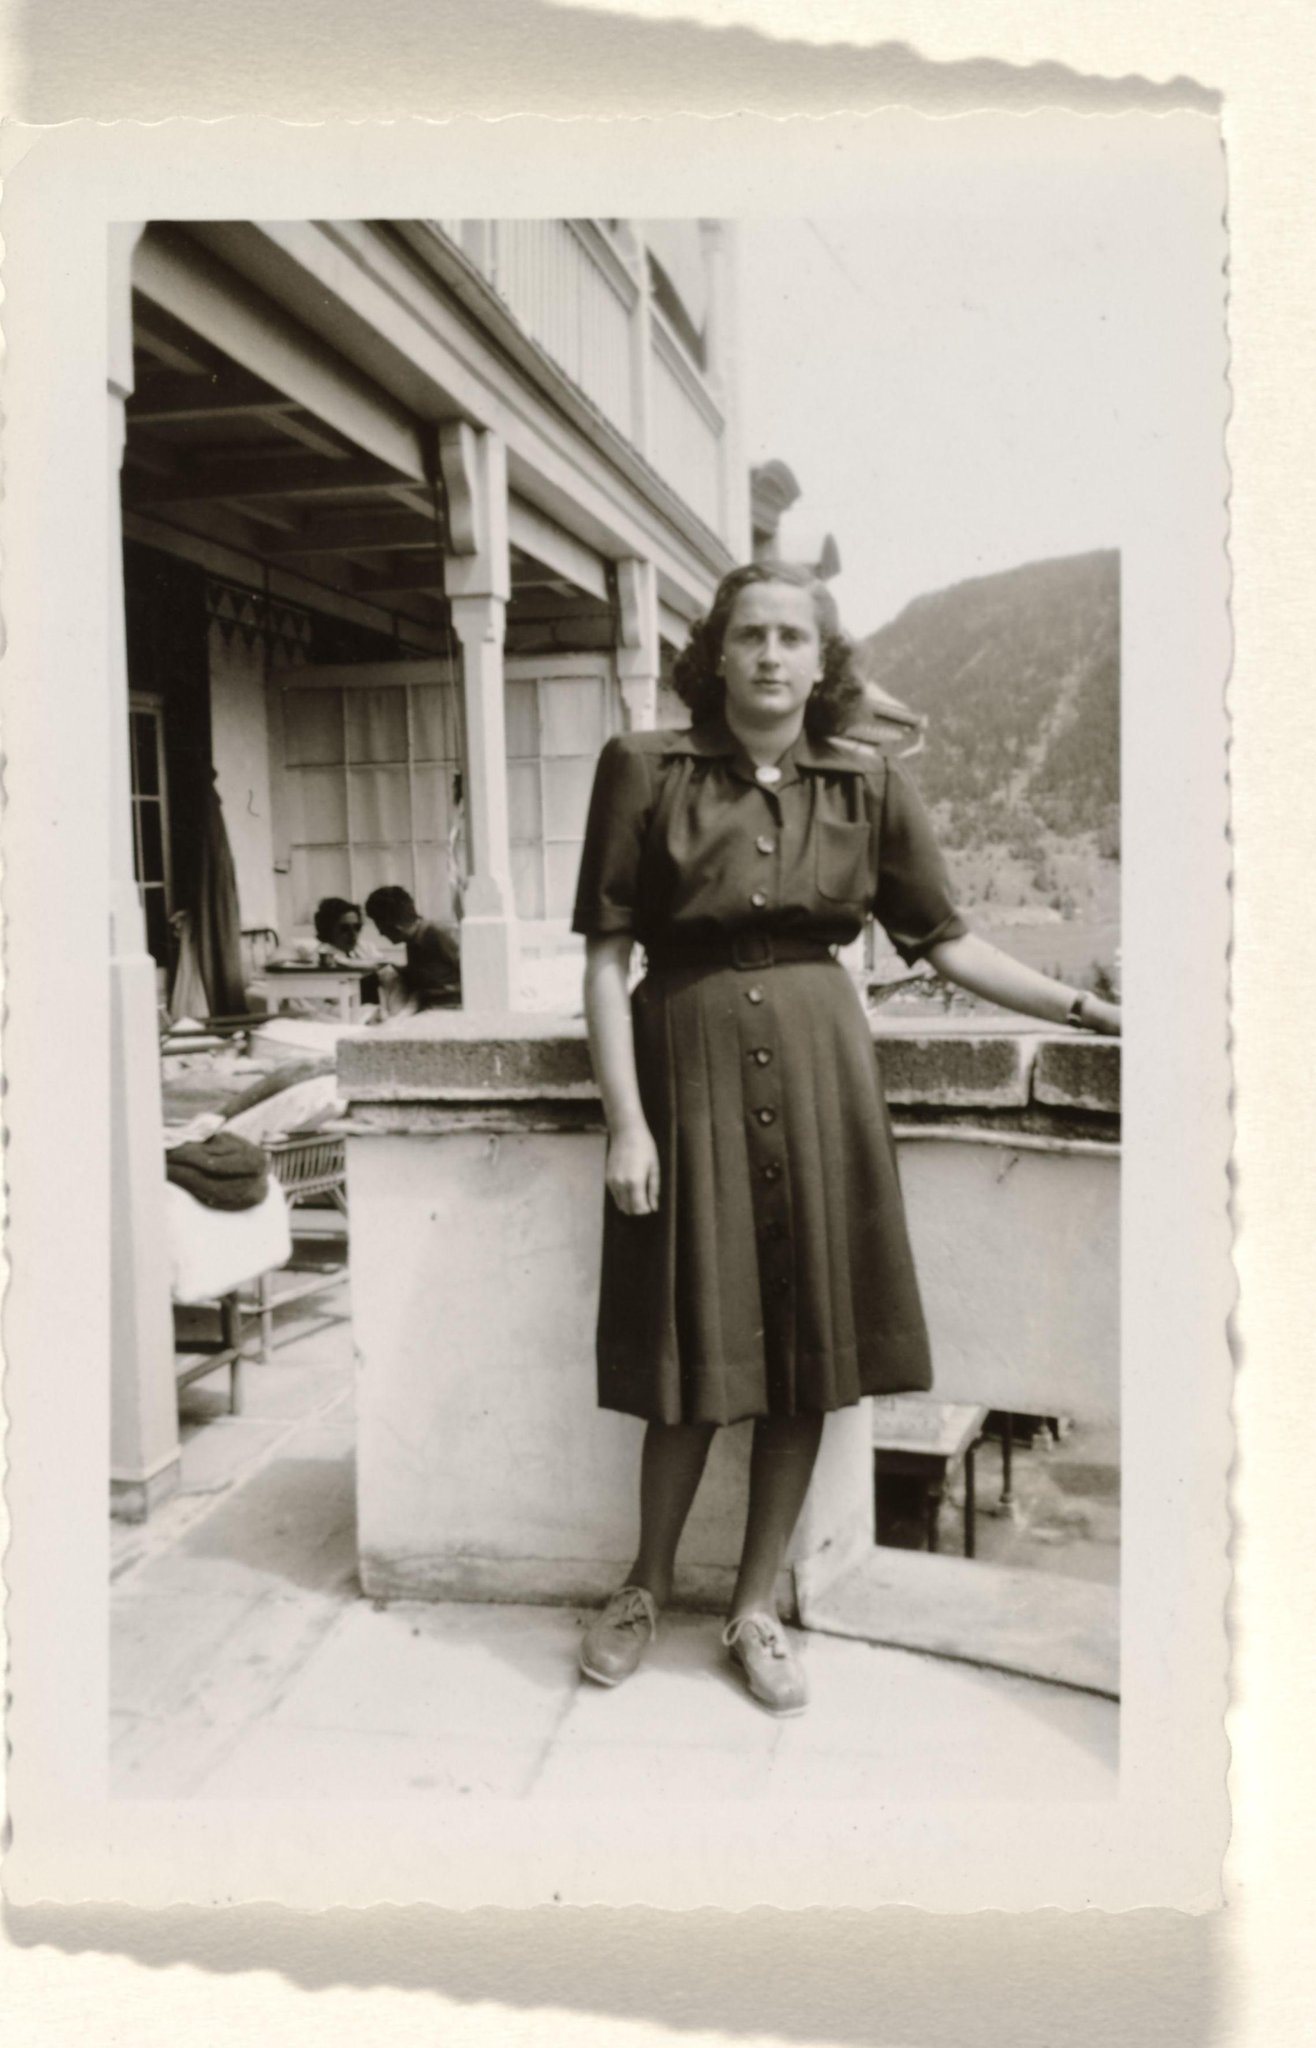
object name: photograph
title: Isabel Wachenheimer staand in donkere kleding voor het Joods sanatorium Etania in Davos, 1945-1947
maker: Anonymous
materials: photographic support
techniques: gelatin silver print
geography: davos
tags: leiden, isabel wachenheimer-elon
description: Isabel Wachenheimer staand in donkere kleding voor het Joods sanatorium Etania in Davos.